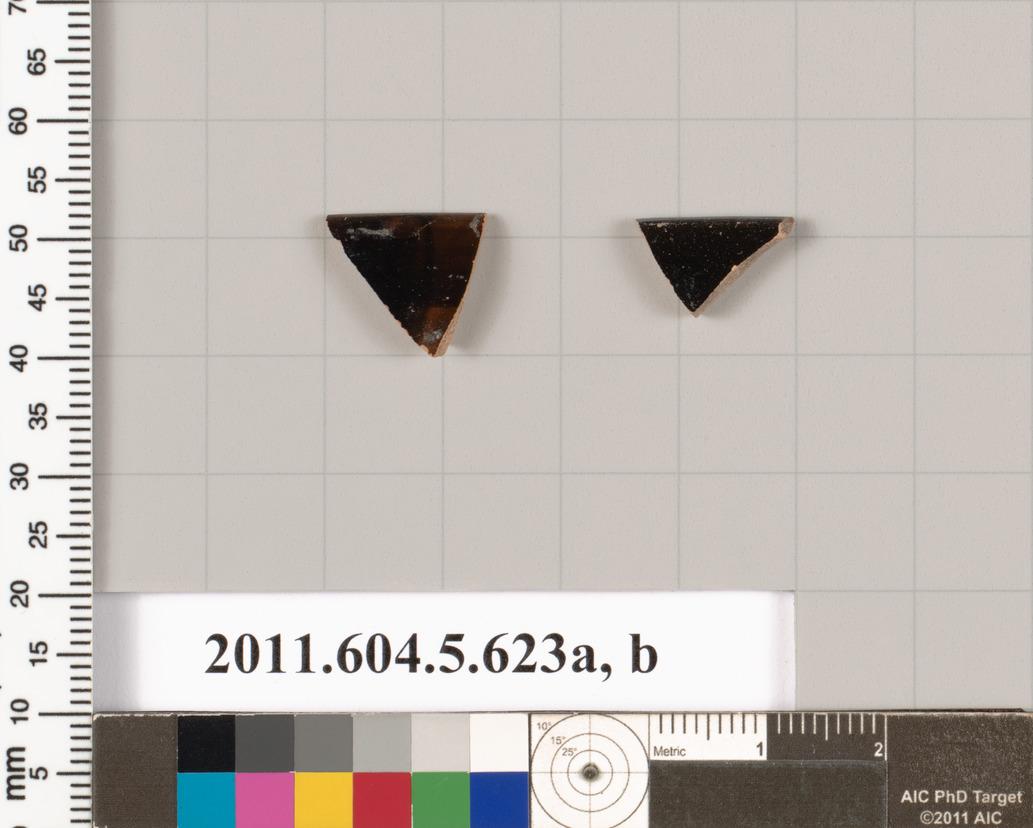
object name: kylix fragment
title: Terracotta rim fragments of kylikes (drinking cups)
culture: greek, attic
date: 600-401 BCE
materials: terracotta